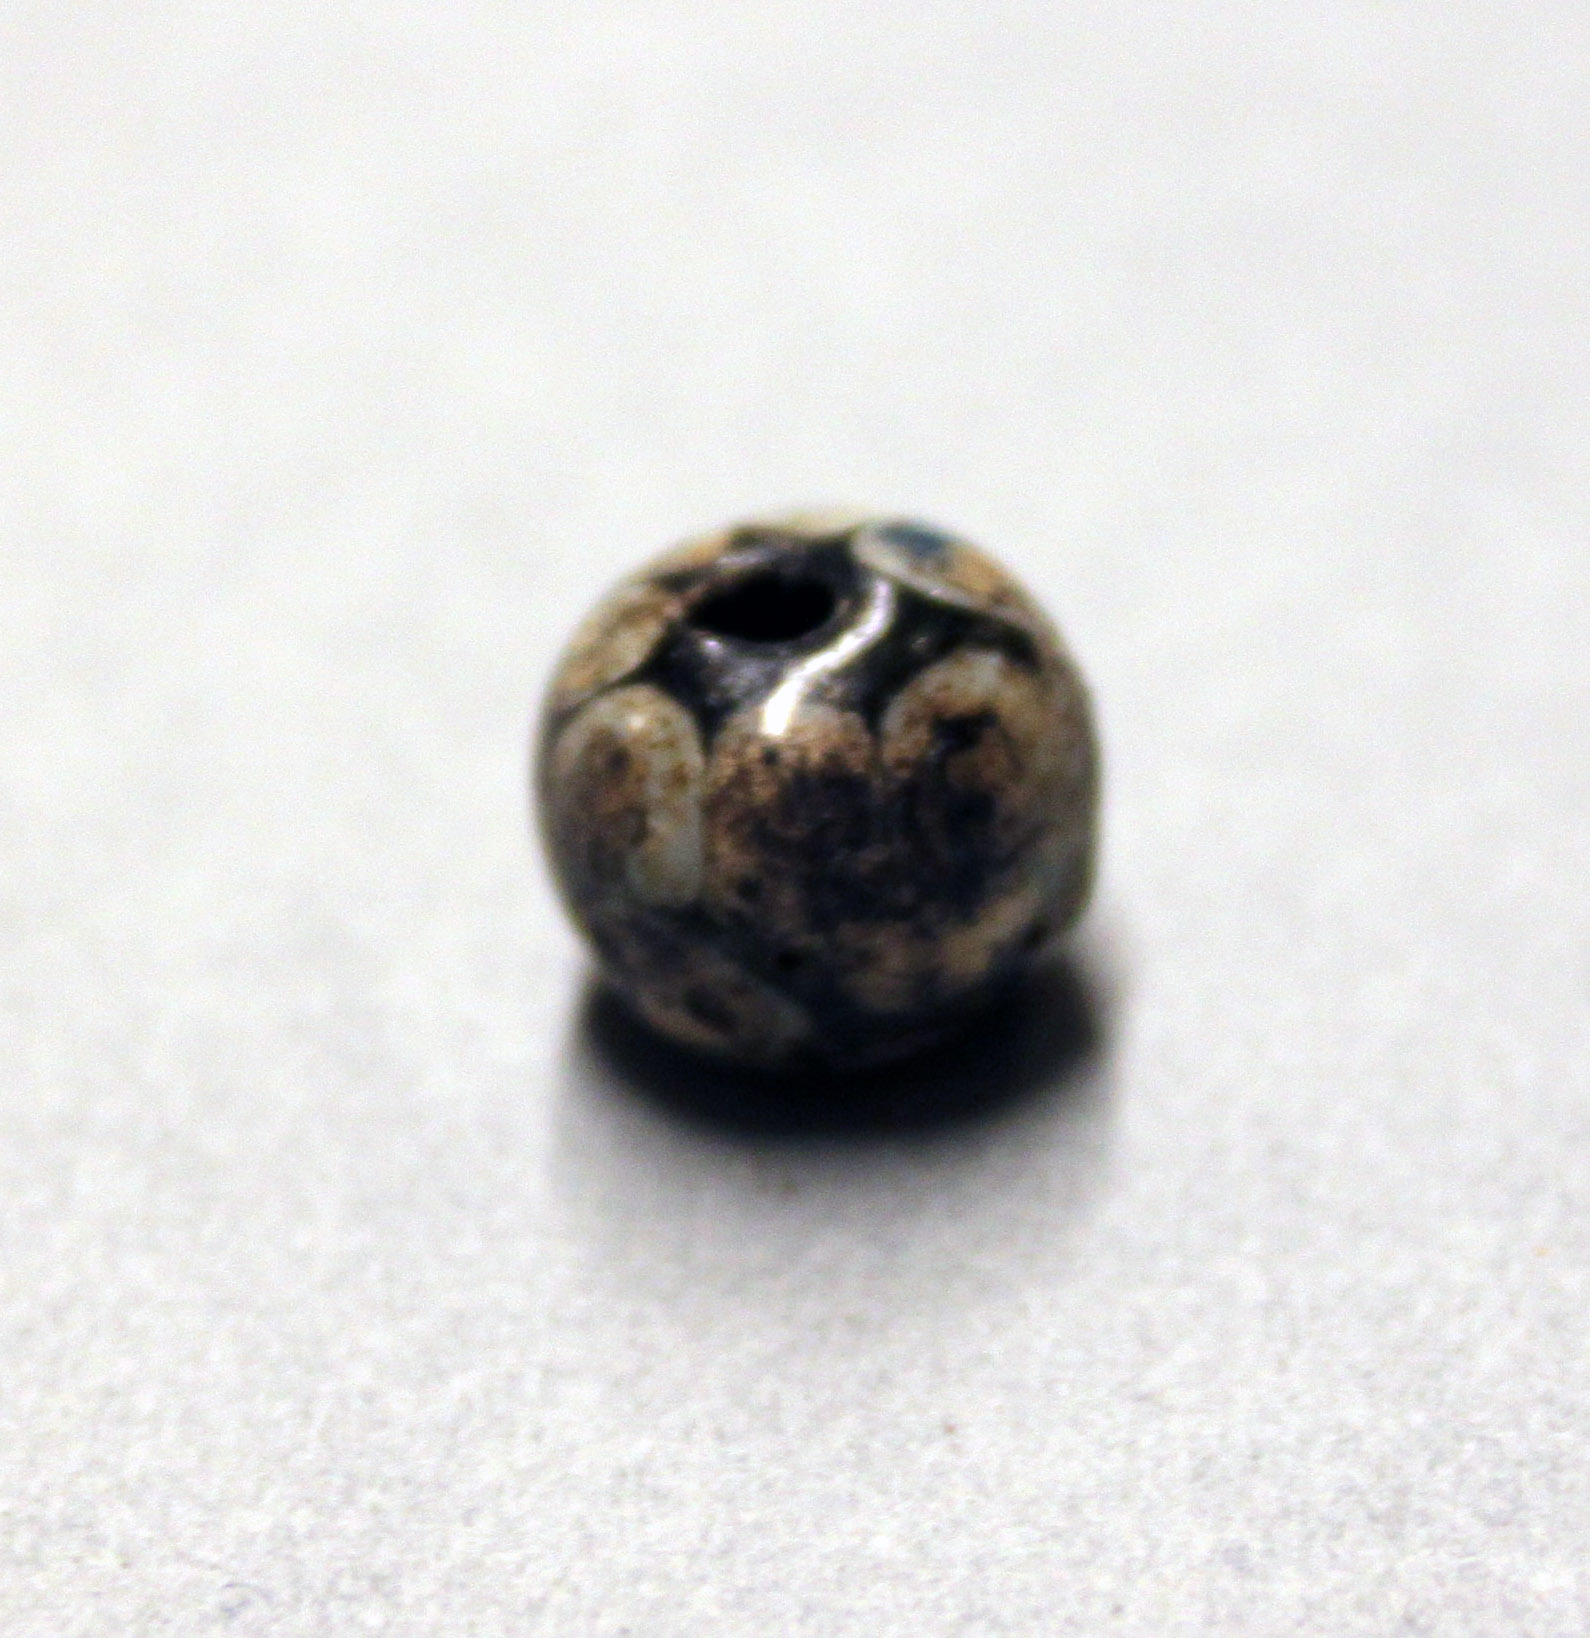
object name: bead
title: Beads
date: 701-1300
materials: glass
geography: iran